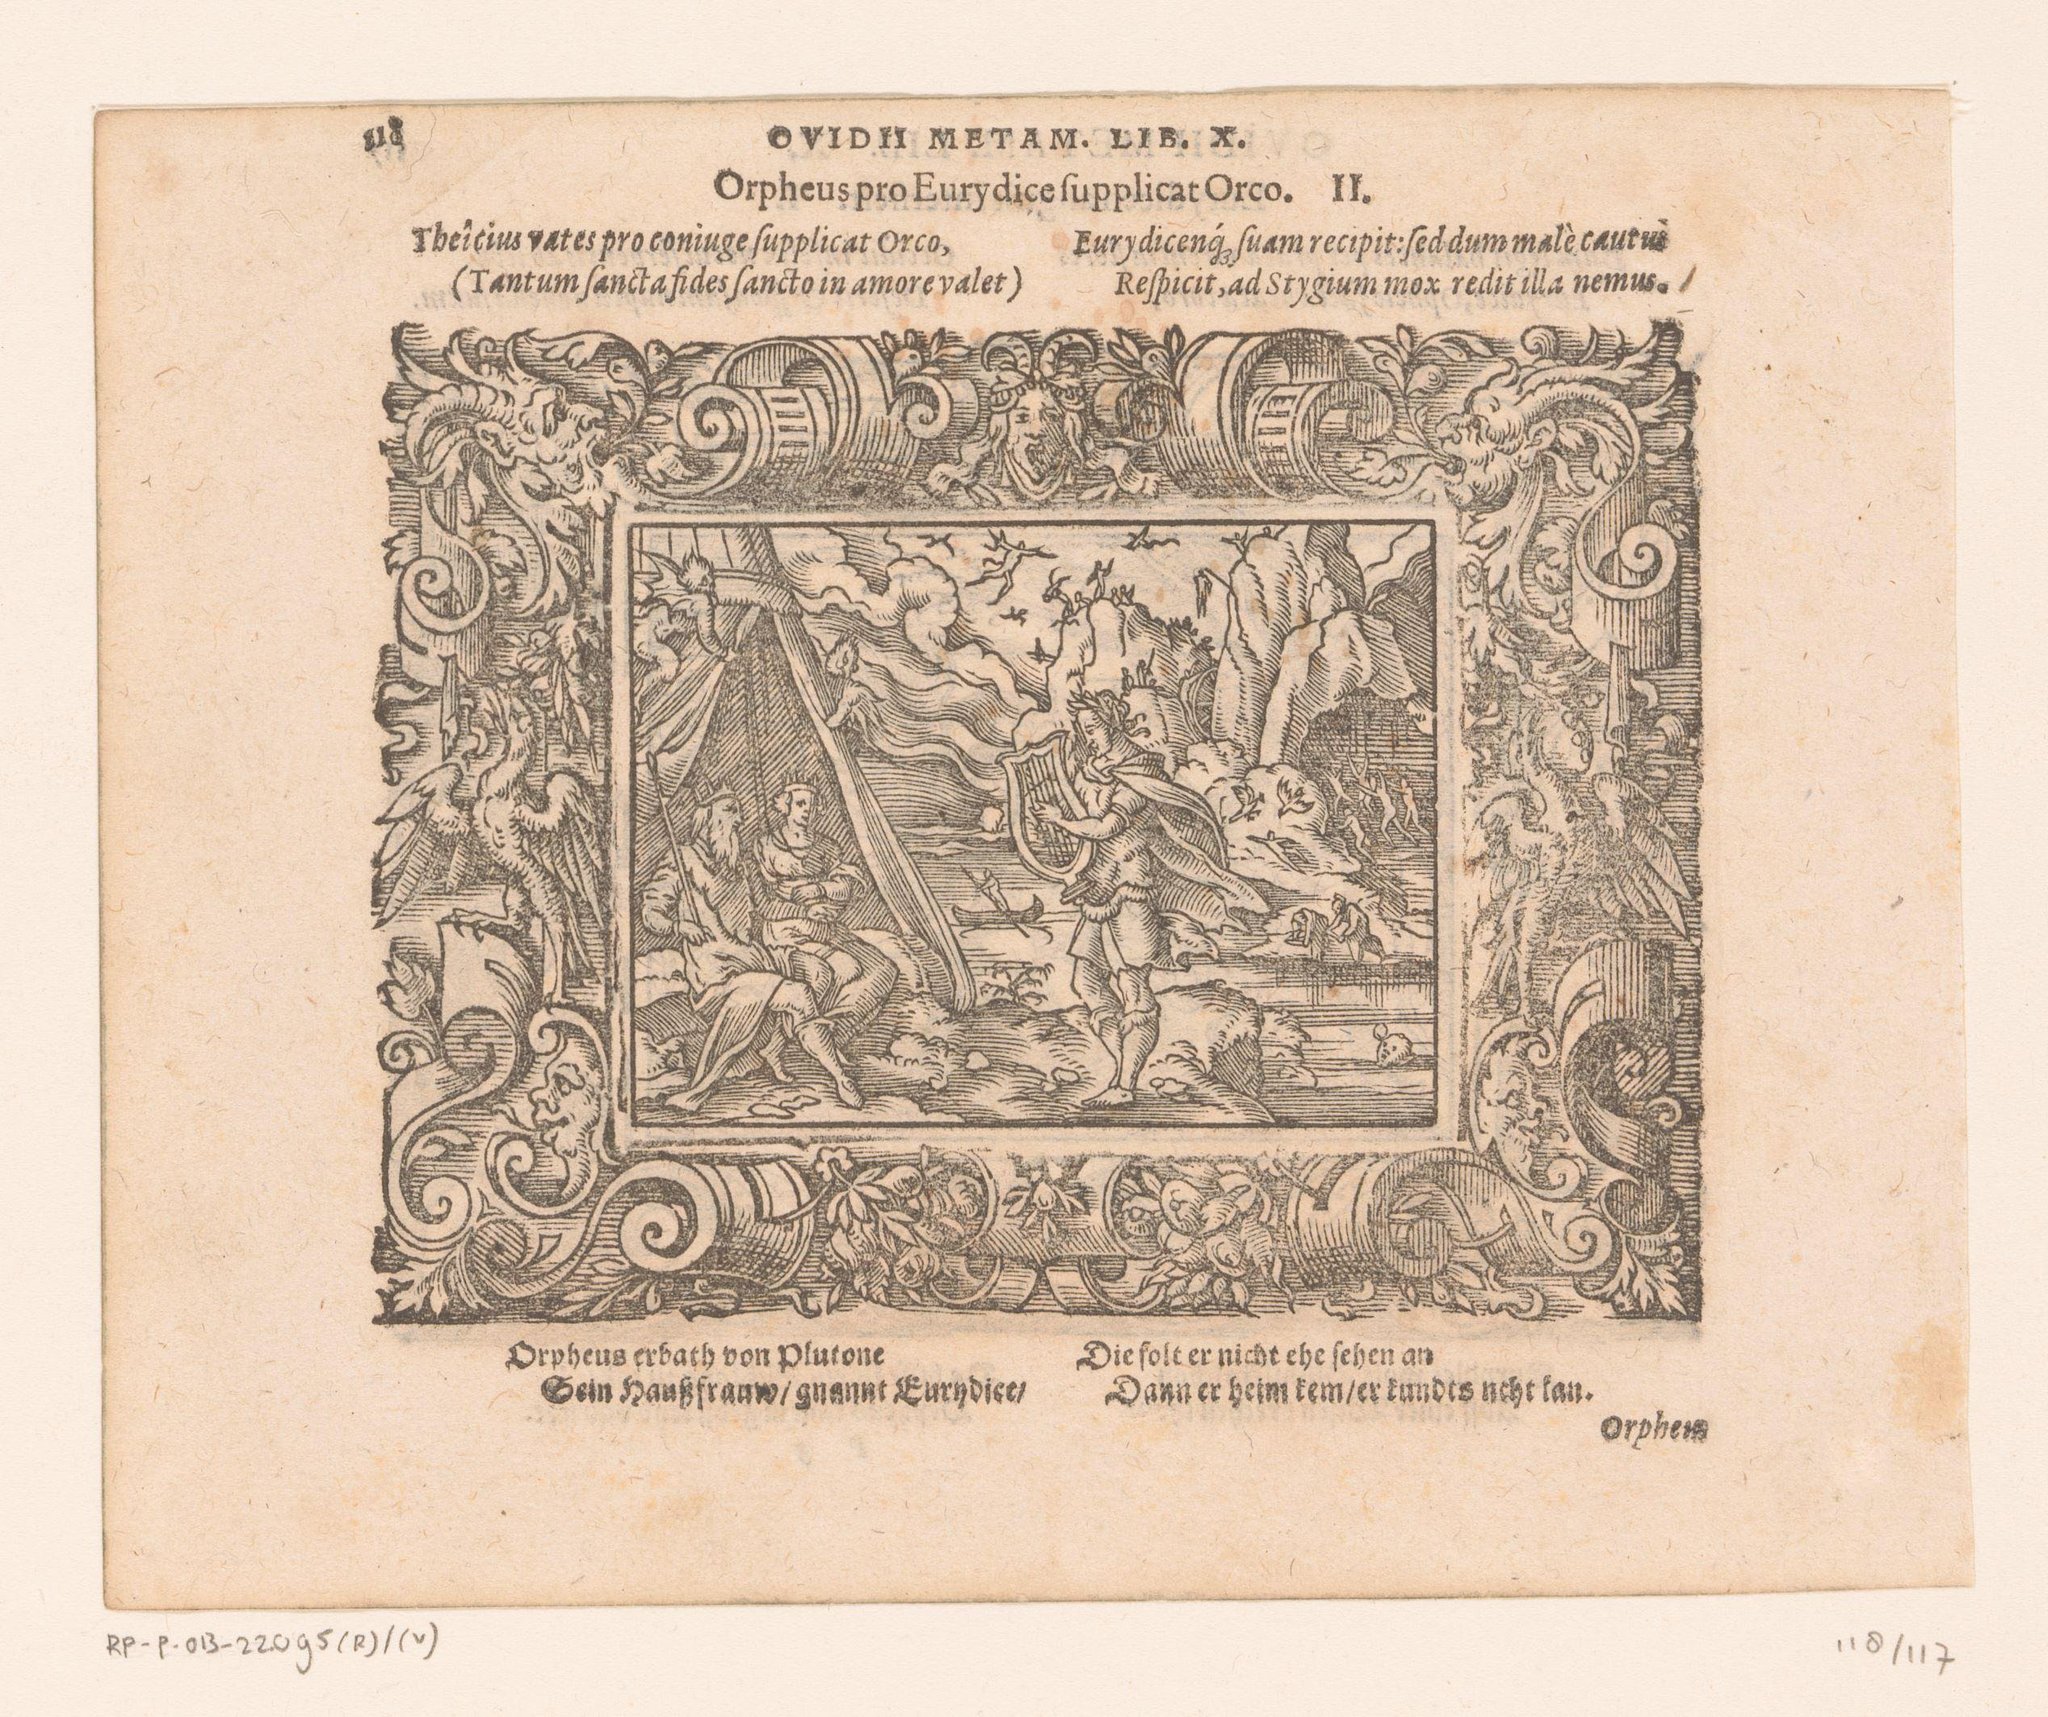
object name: print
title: Orpheus pro Eurydice supplicat Orco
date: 1569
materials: paper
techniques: letterpress printing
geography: frankfurt am main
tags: scrollwork, strapwork ~ ornament, through his music orpheus induces pluto and/or proserpina to let eurydice go, charon, the ferryman, hades, the underworld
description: Illustratie bij de Metamorfosen van Ovidius, afkomstig uit de publicatie: Posthius, Johannes. Tetrasticha in Ovidii metam. Frankfurt am Main: Georg Rab en Sigmund Feyerabend en erven Weigand Han, 1569. De voorstellingen en ornamentranden van deze boekillustraties zijn van twee aparte blokken gedrukt. Beide werden afzonderlijk van elkaar ook gebruikt voor andere publicaties, en de ornamentranden werden eveneens binnen deze publicatie meerdere keren gebruikt.